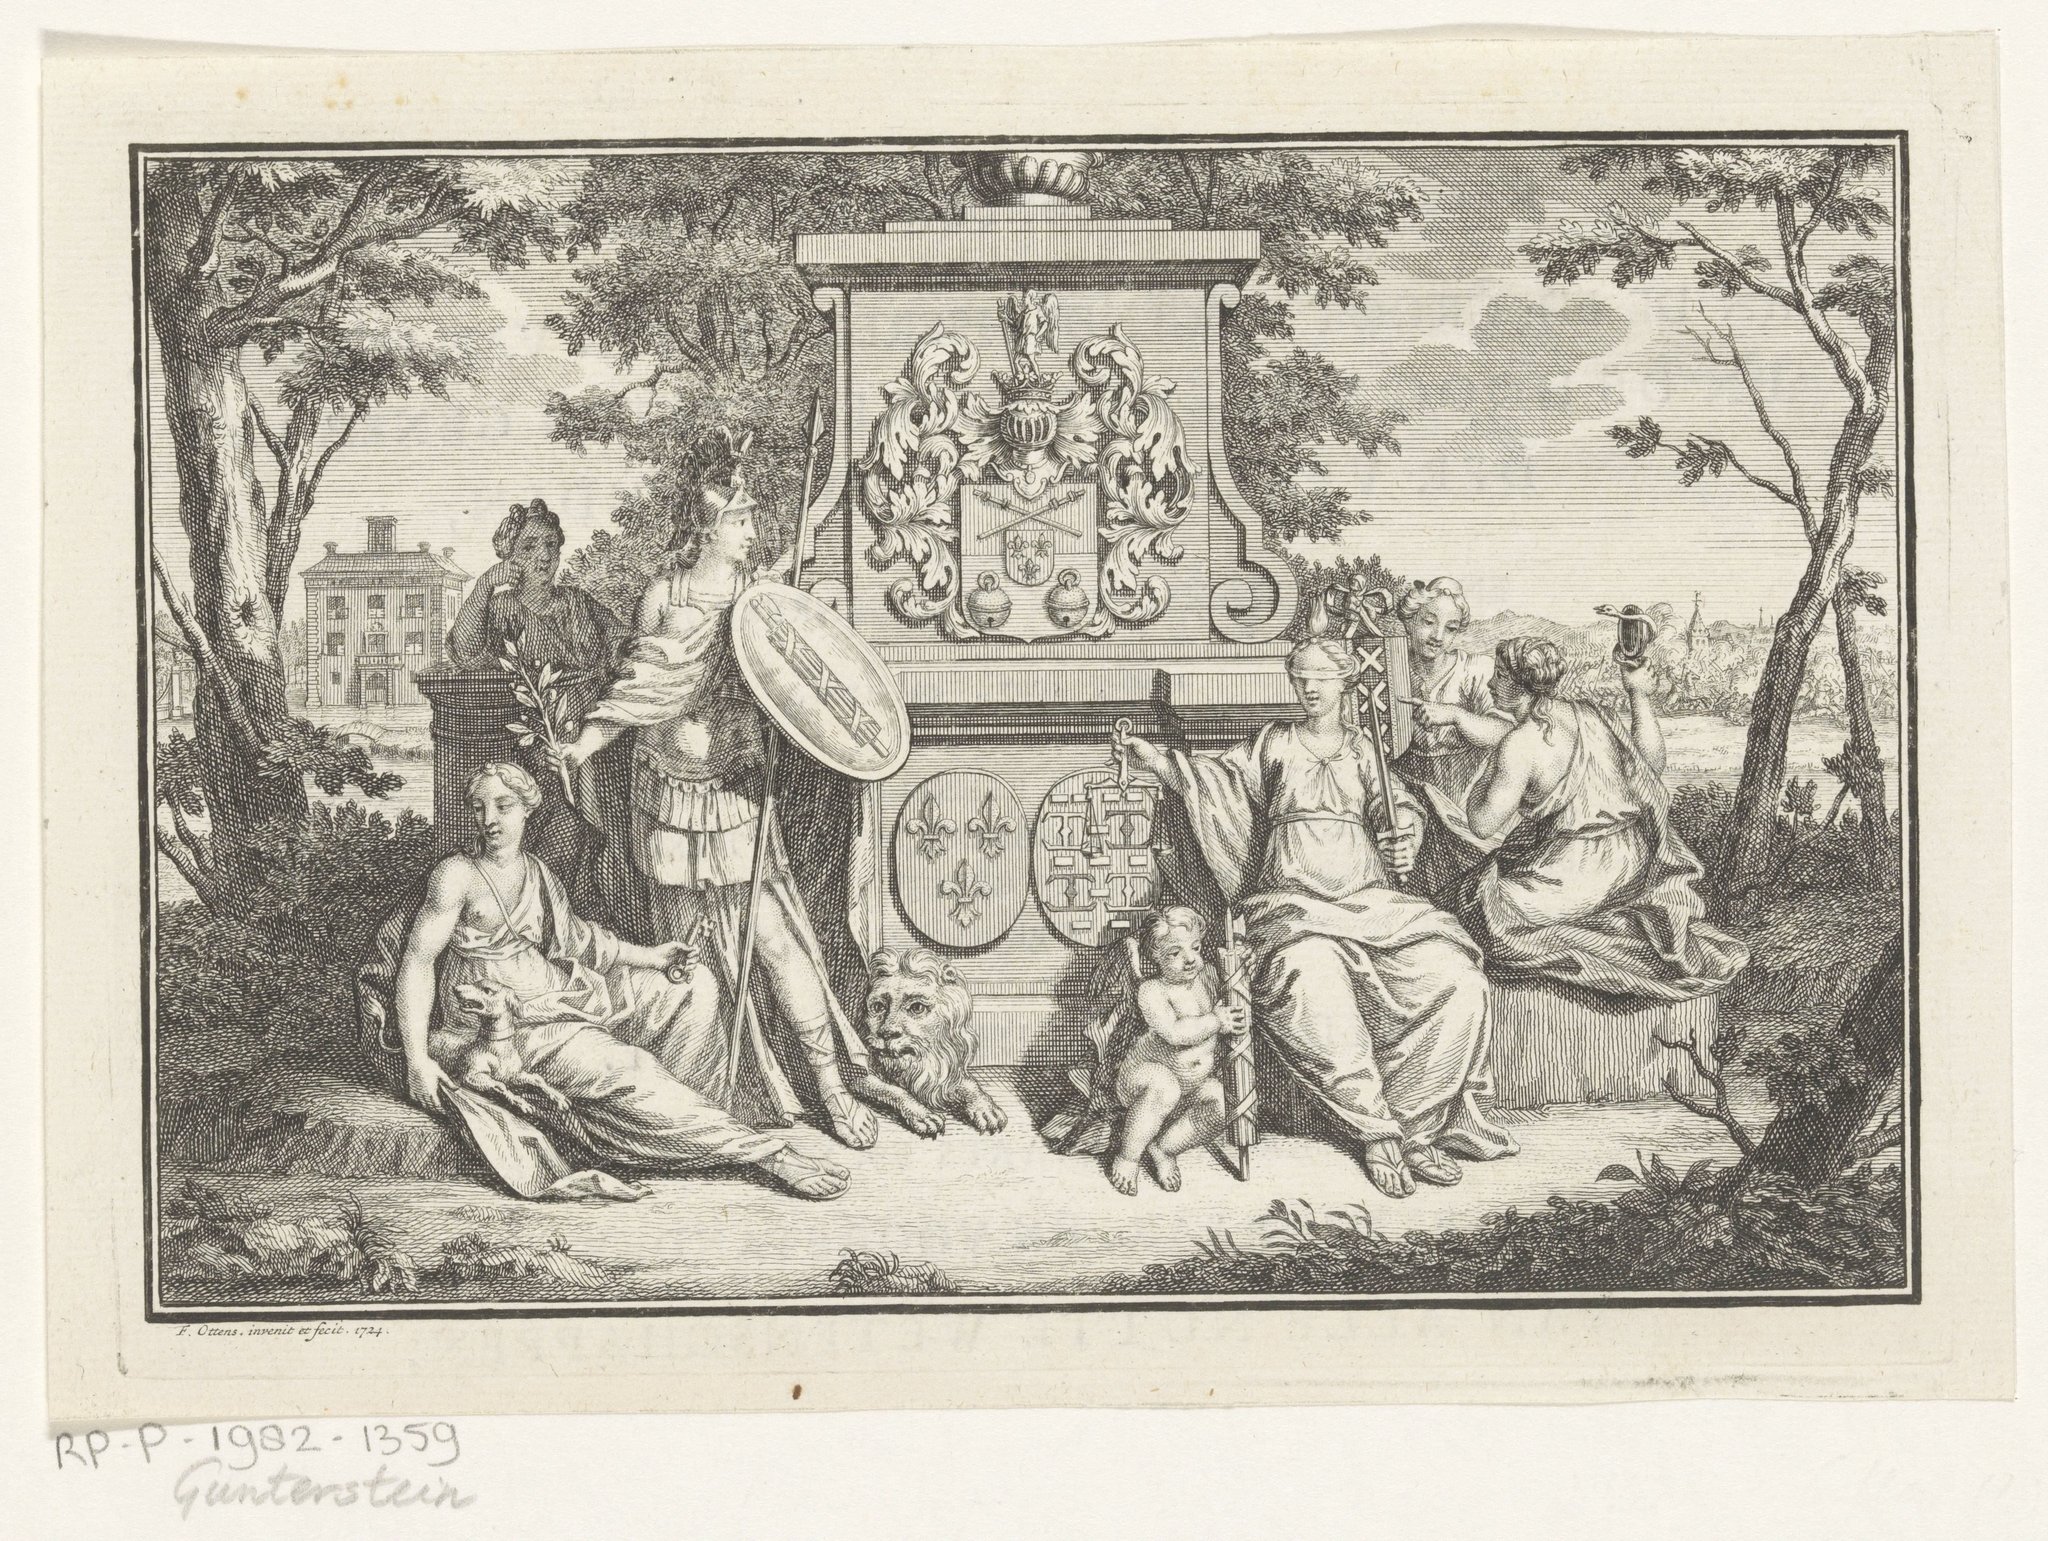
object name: book illustration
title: Allegorische voorstelling als eerbetoon aan Ferdinand van Collen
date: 1724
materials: paper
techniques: engraving, etching, letterpress printing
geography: leeuwarden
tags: ferdinand van collen, coat of arms (as symbol of the state, etc.), justitia (justice) as roman personification, armorial bearing, heraldry, amsterdam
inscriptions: collector's mark: Lugt 2228, collector's mark: Lugt 2760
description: Rond een monument met familiewapen van het geslacht Collen en de wapenschilden van Gunterstein en Tienhoven staan allegorische vrouwenfiguren. Rechts Rechtvaardigheid met naast haar Amor die een fasces draagt. Achter Rechtvaardigheid een vrouw die het Amsterdamse stadswapen toont. Links op de achtergrond een buitenplaats, rechts is een veldslag aan de gang. Eerbetoon aan Ferdinand van Collen.